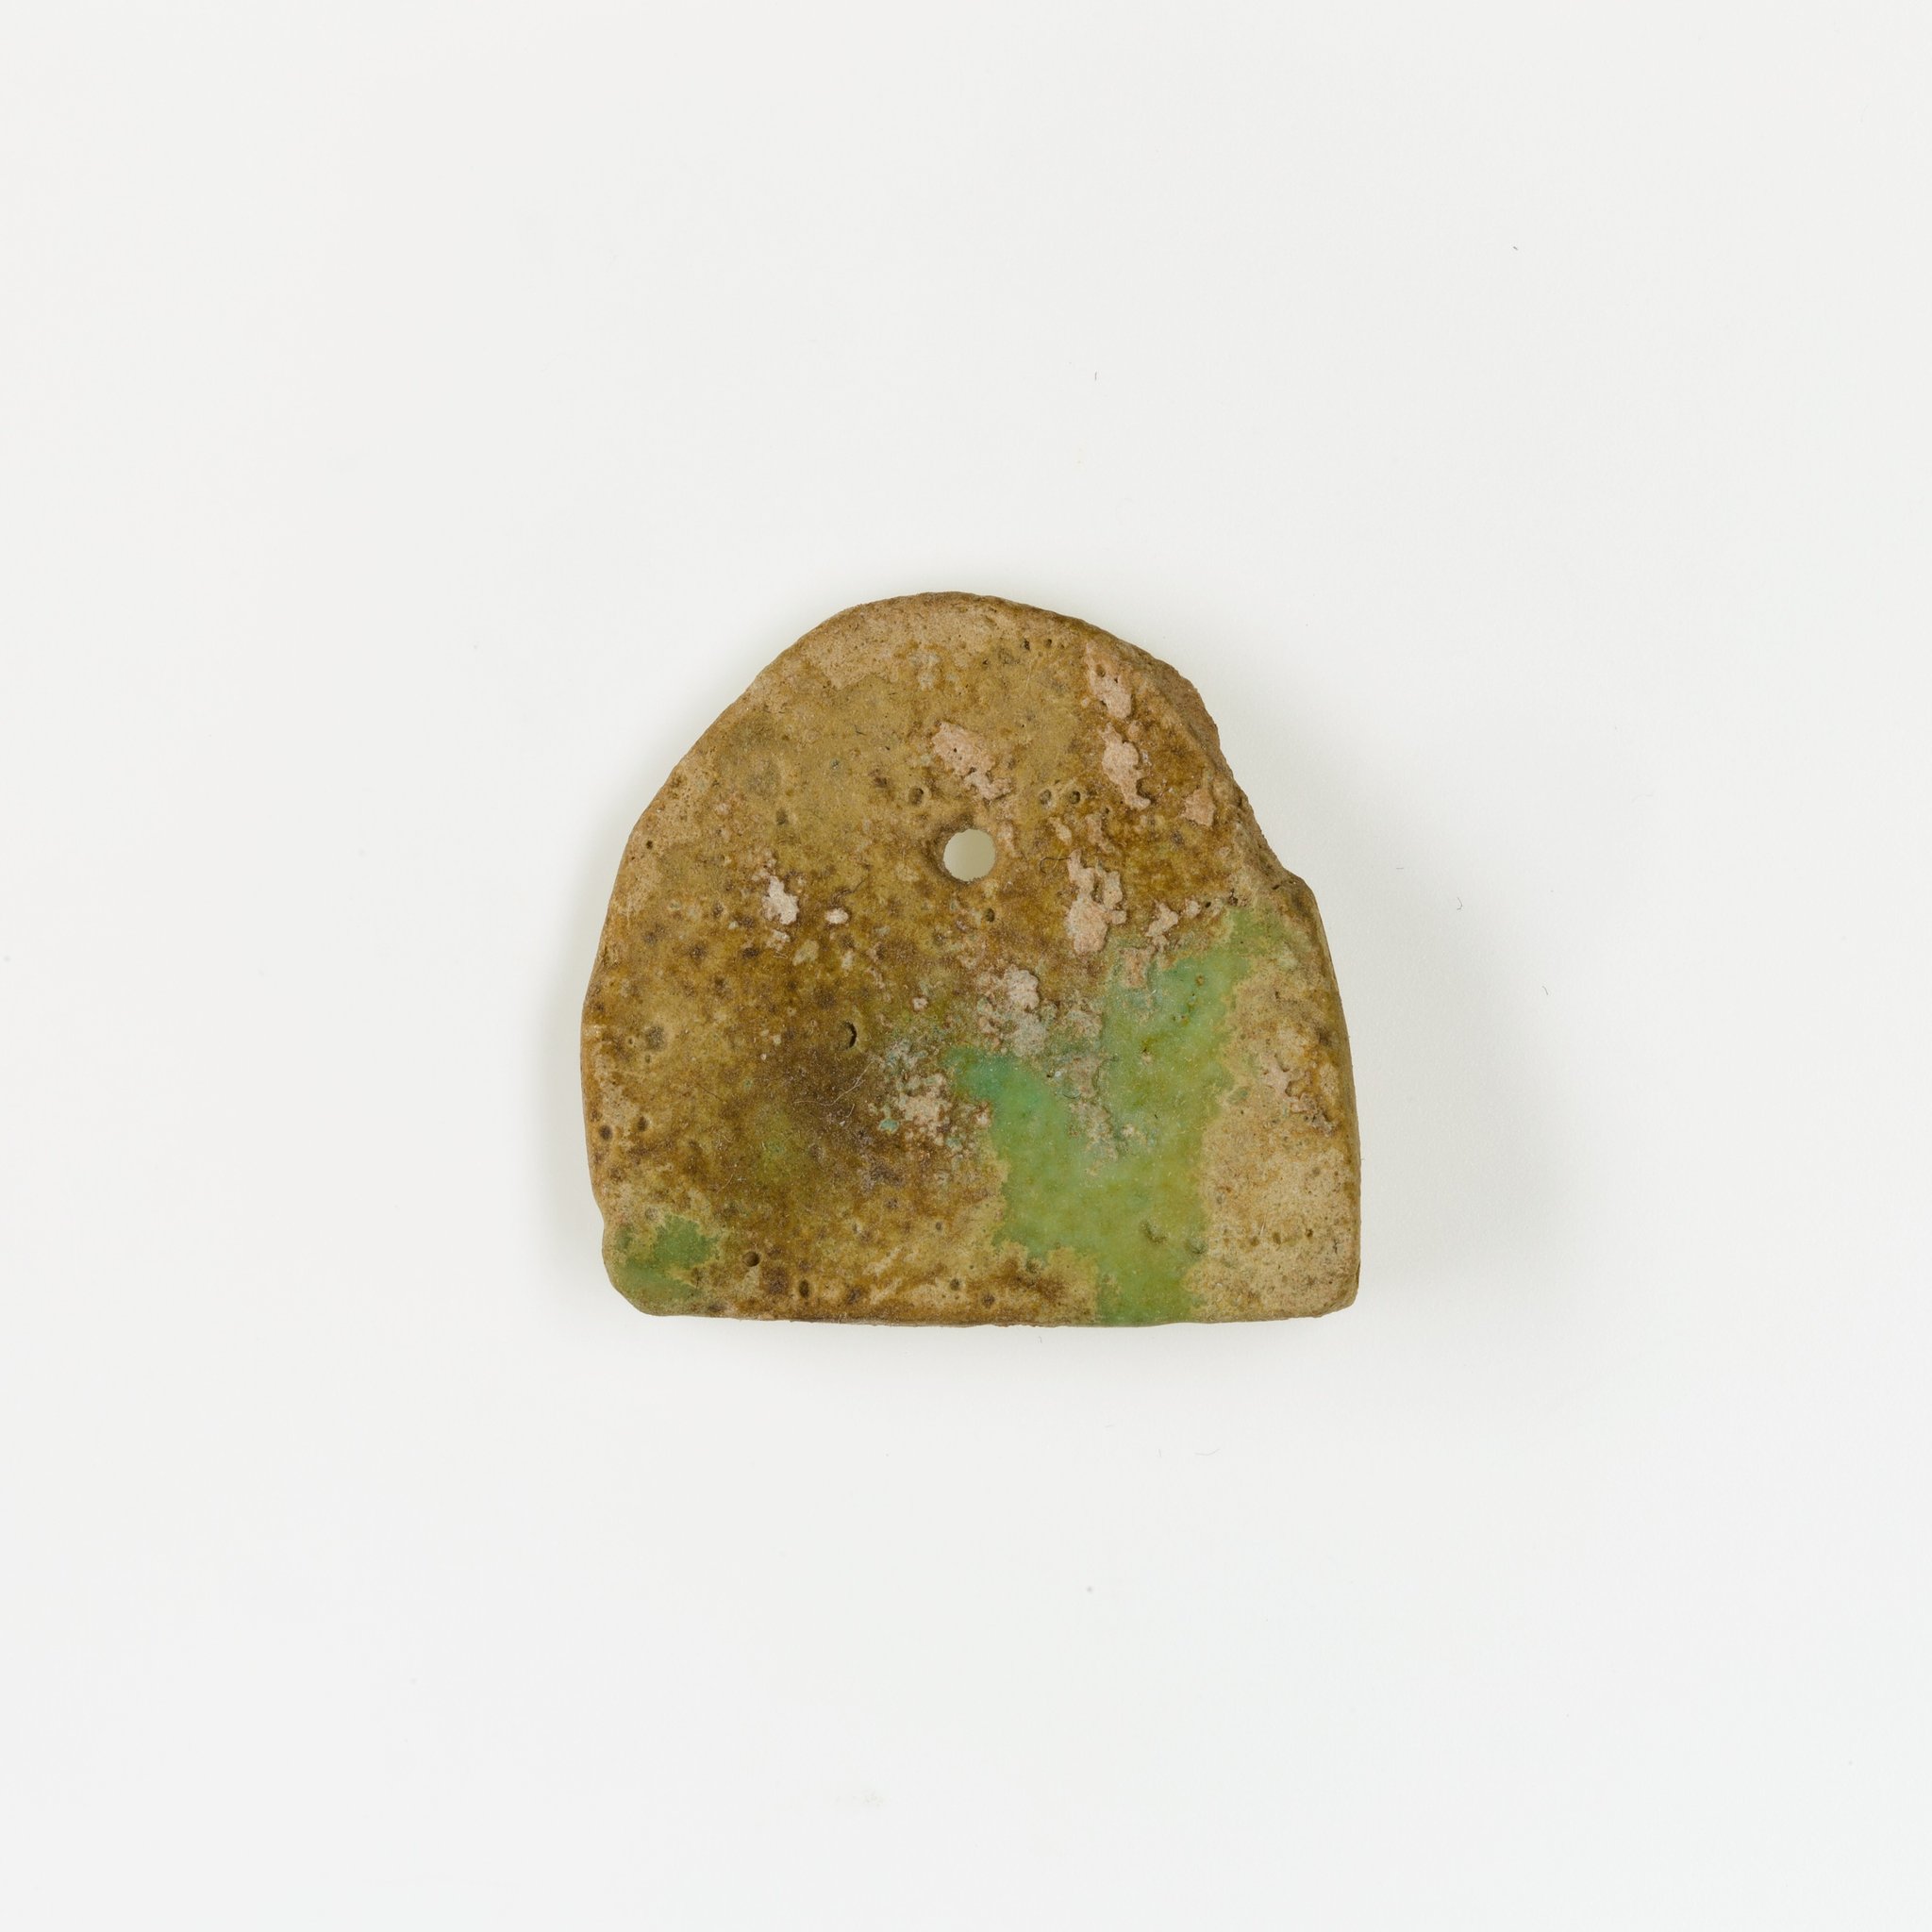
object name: broad collar piece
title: Broad Collar piece (?)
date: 1850-1640 BCE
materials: faience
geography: egypt